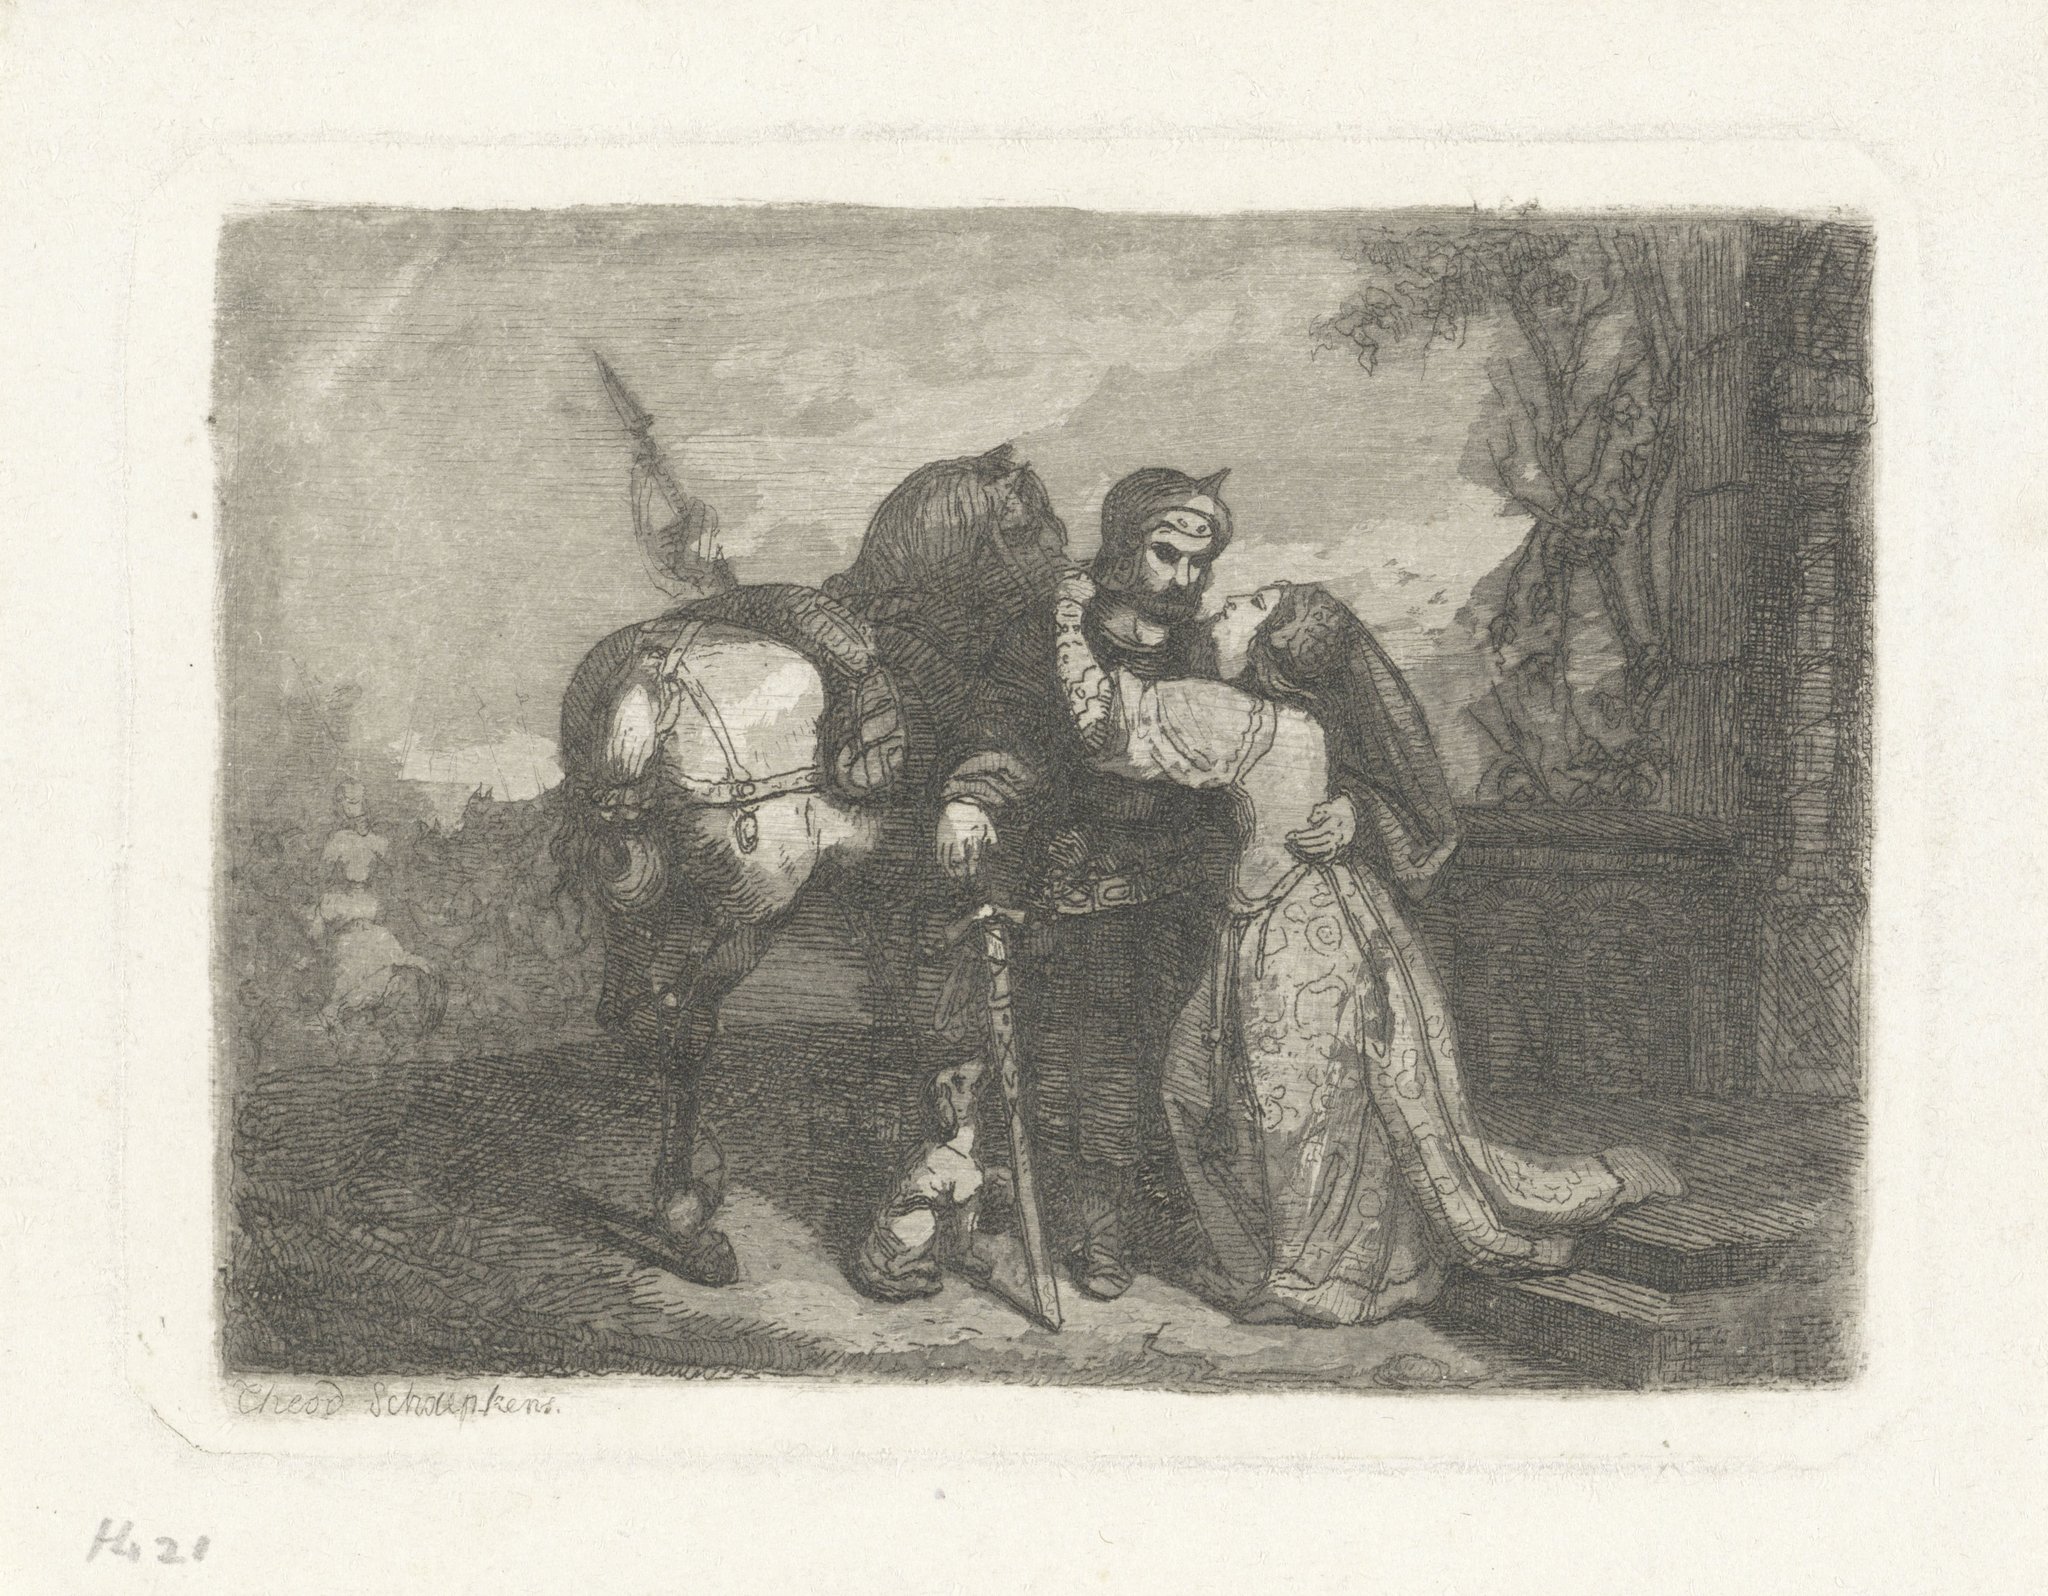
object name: print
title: Vrouw neemt afscheid van een ridder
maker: theodoor schaepkens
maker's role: draughtsman, print maker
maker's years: 1810-1883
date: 1820-1882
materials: paper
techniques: aquatint, etching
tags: (lovers) embracing each other, 'symplegma', departure ~ travelling, knight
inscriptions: collector's mark: Lugt 2228